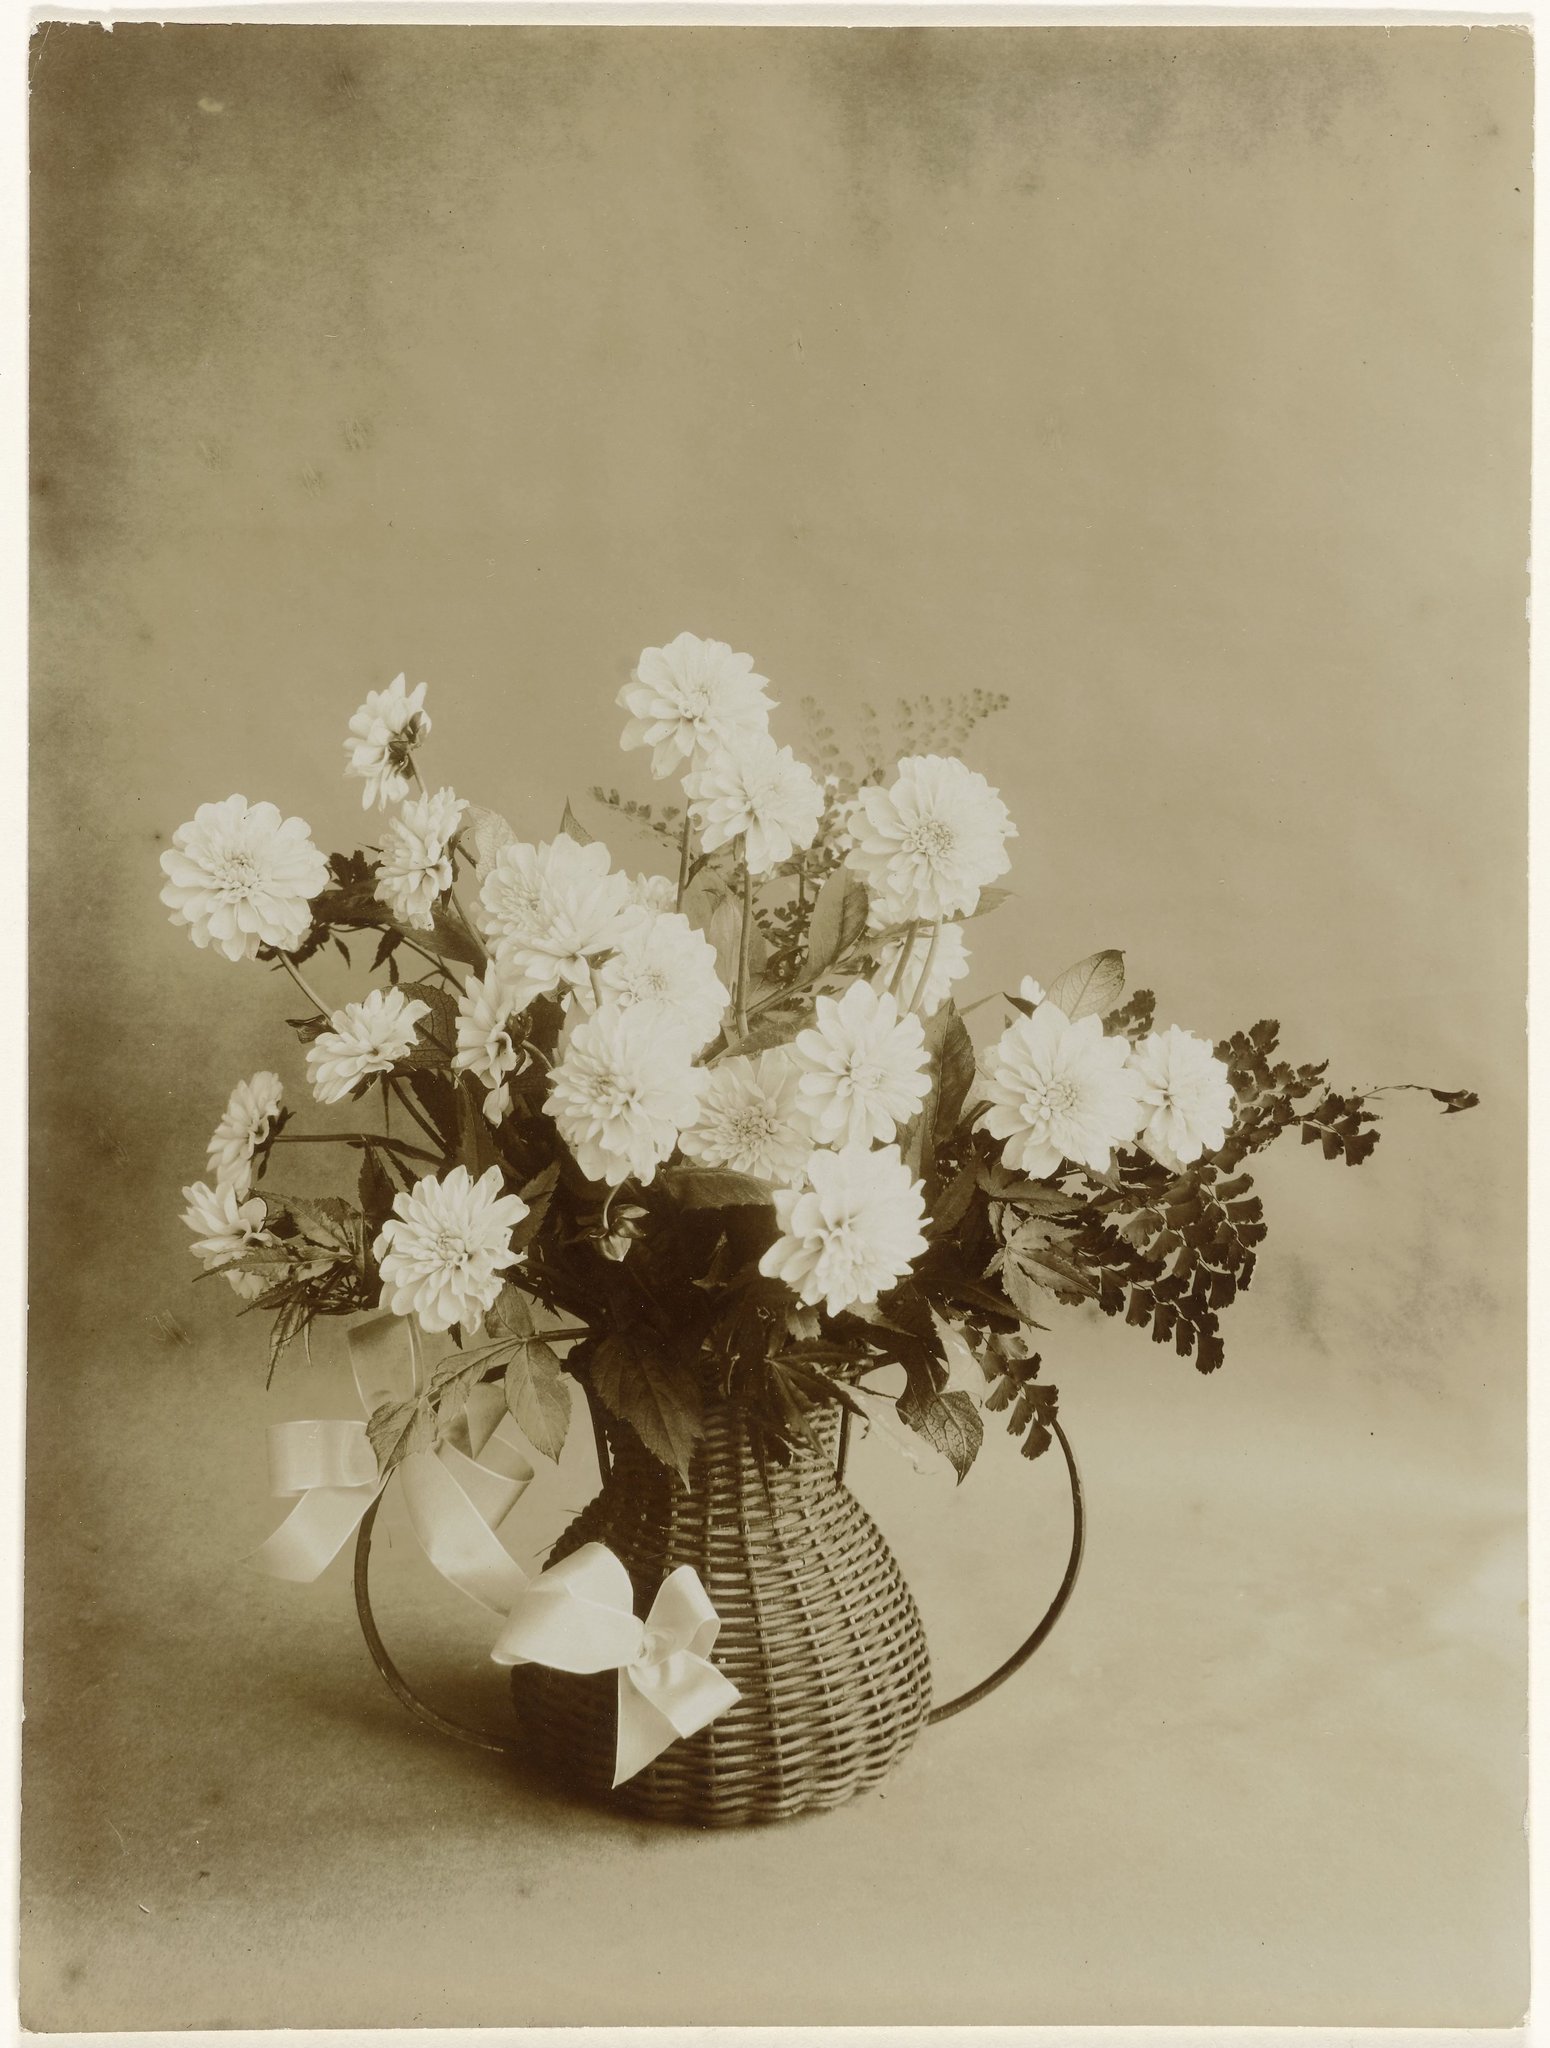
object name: photograph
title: Dahlia's geschikt in bloemenmand door de heer B.H. Wagenvoorde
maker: richard tepe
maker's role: fotograaf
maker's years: 1864-1952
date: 1900-1940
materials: photographic support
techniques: gelatin silver print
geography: netherlands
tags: flowers in a vase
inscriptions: : ‘Rosette Dahlie / Juweeltje, / in einem Korb / Rosette Dahlia / "Juweeltje / geschikt in een bloemenmandje / door den heer B.H Wagenvoorde / Bloemenmagazijn de Lelie / te Apeldoorn’, signature: ‘foto / R. Tepe’